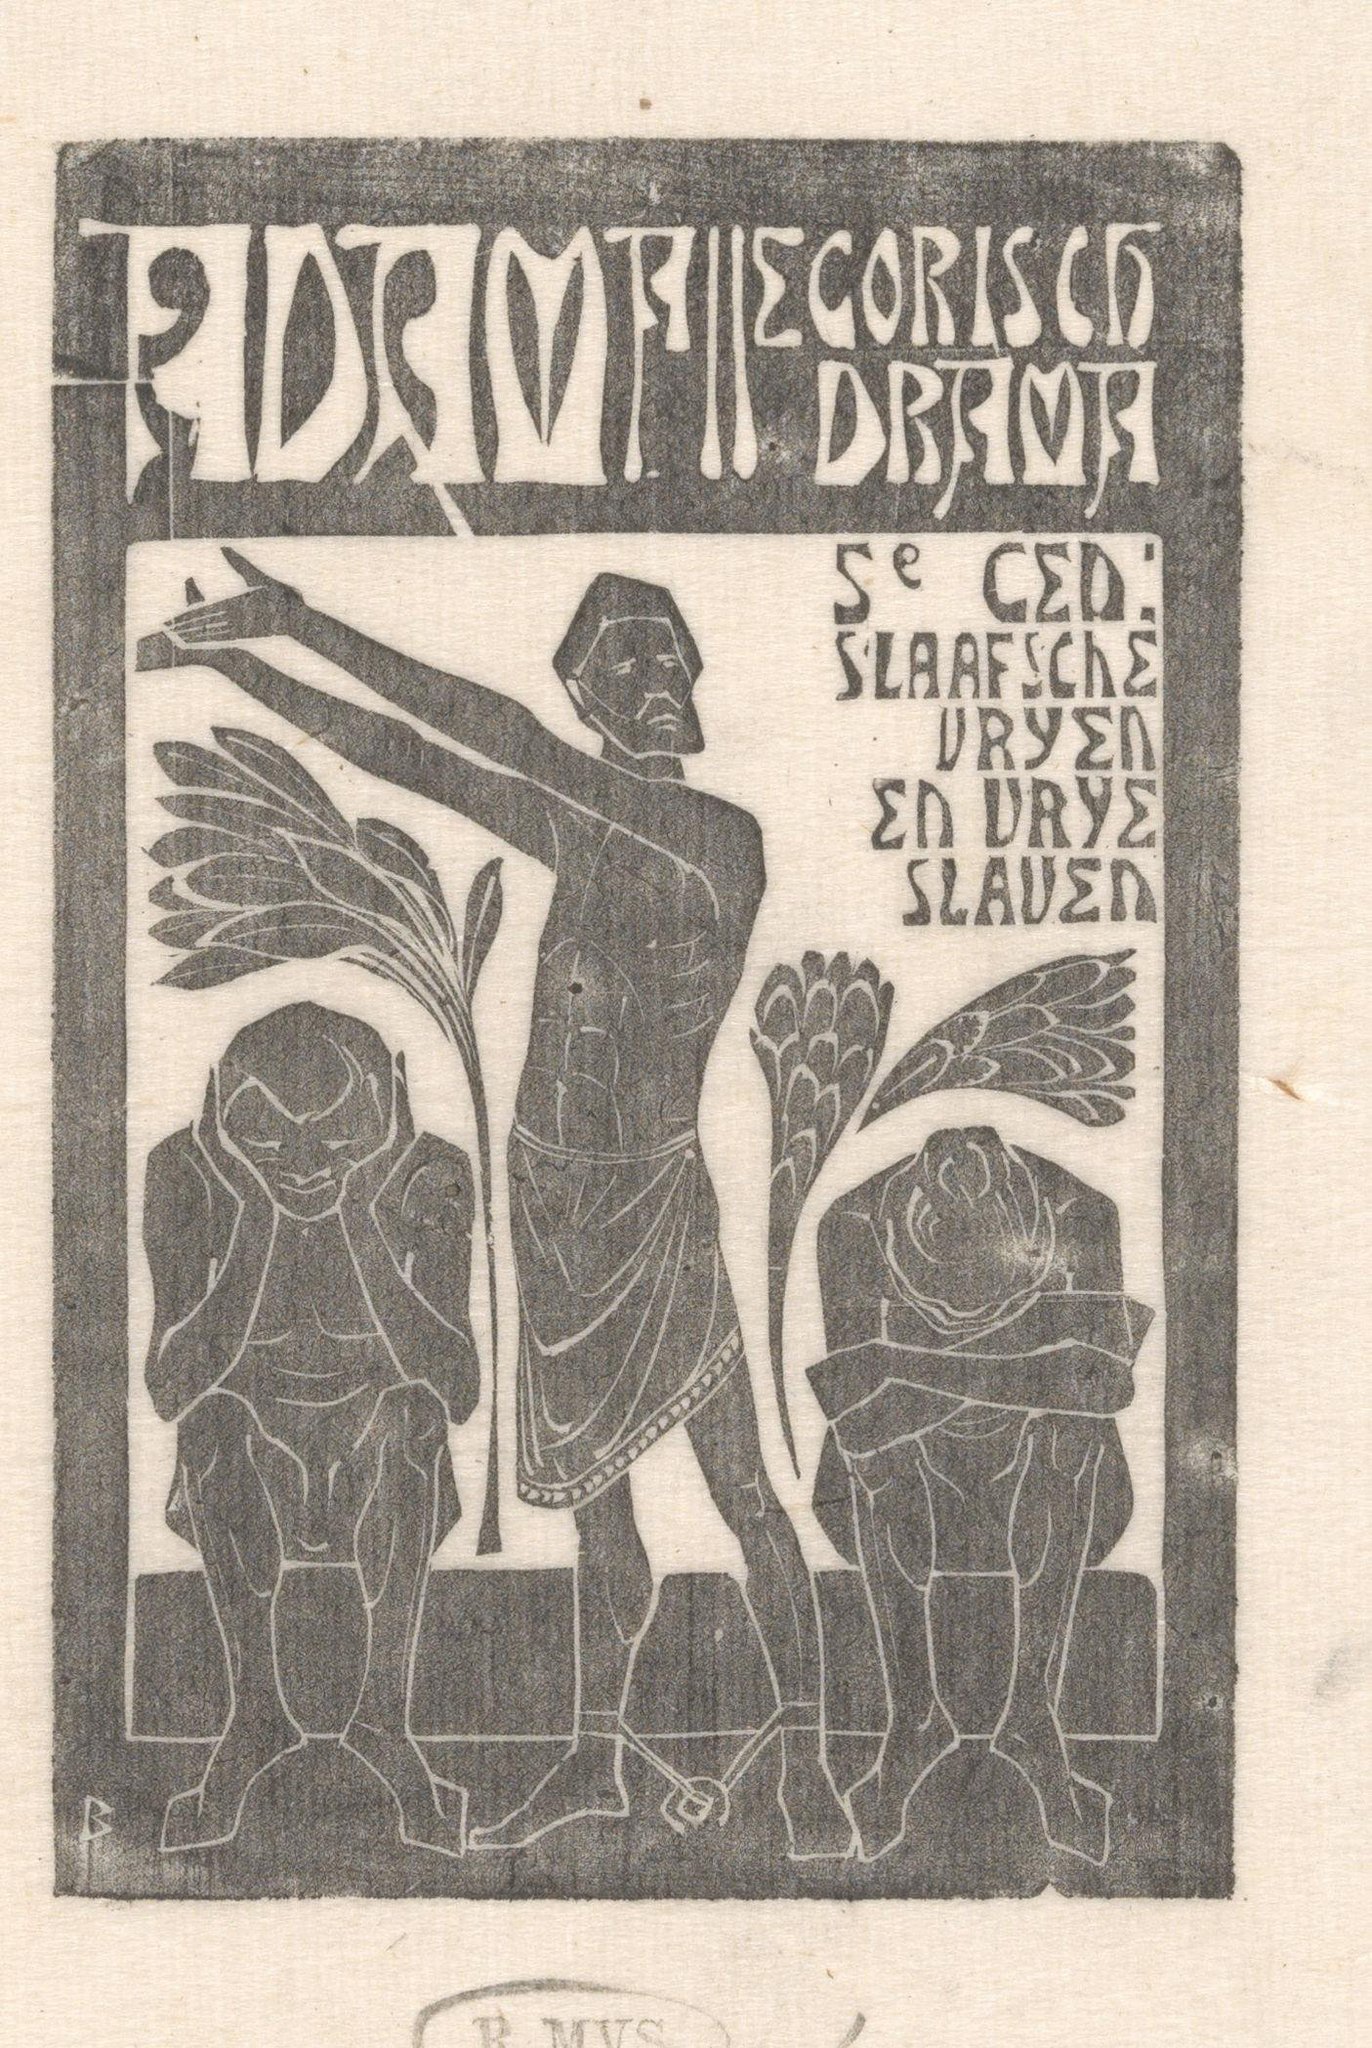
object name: admission ticket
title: Toegangsbewijs voor deel vijf van Adam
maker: karel petrus cornelis de bazel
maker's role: draughtsman, print maker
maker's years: 1869-1923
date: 1912-1934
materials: paper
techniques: woodcut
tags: slavery; serfs and enslaved persons, freedom ~ slavery, printed matter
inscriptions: collector's mark: Lugt 2228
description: Toegangskaart voor het vijfde gedeelte van het allegorisch drama 'Adam', 'Slaafsche vrijen en vrije slaven', met een afbeelding van een naakte, zittende man en vrouw met gebukt hoofd. Tussen hen in een staande, halfnaakte man met vastgeketende enkels.